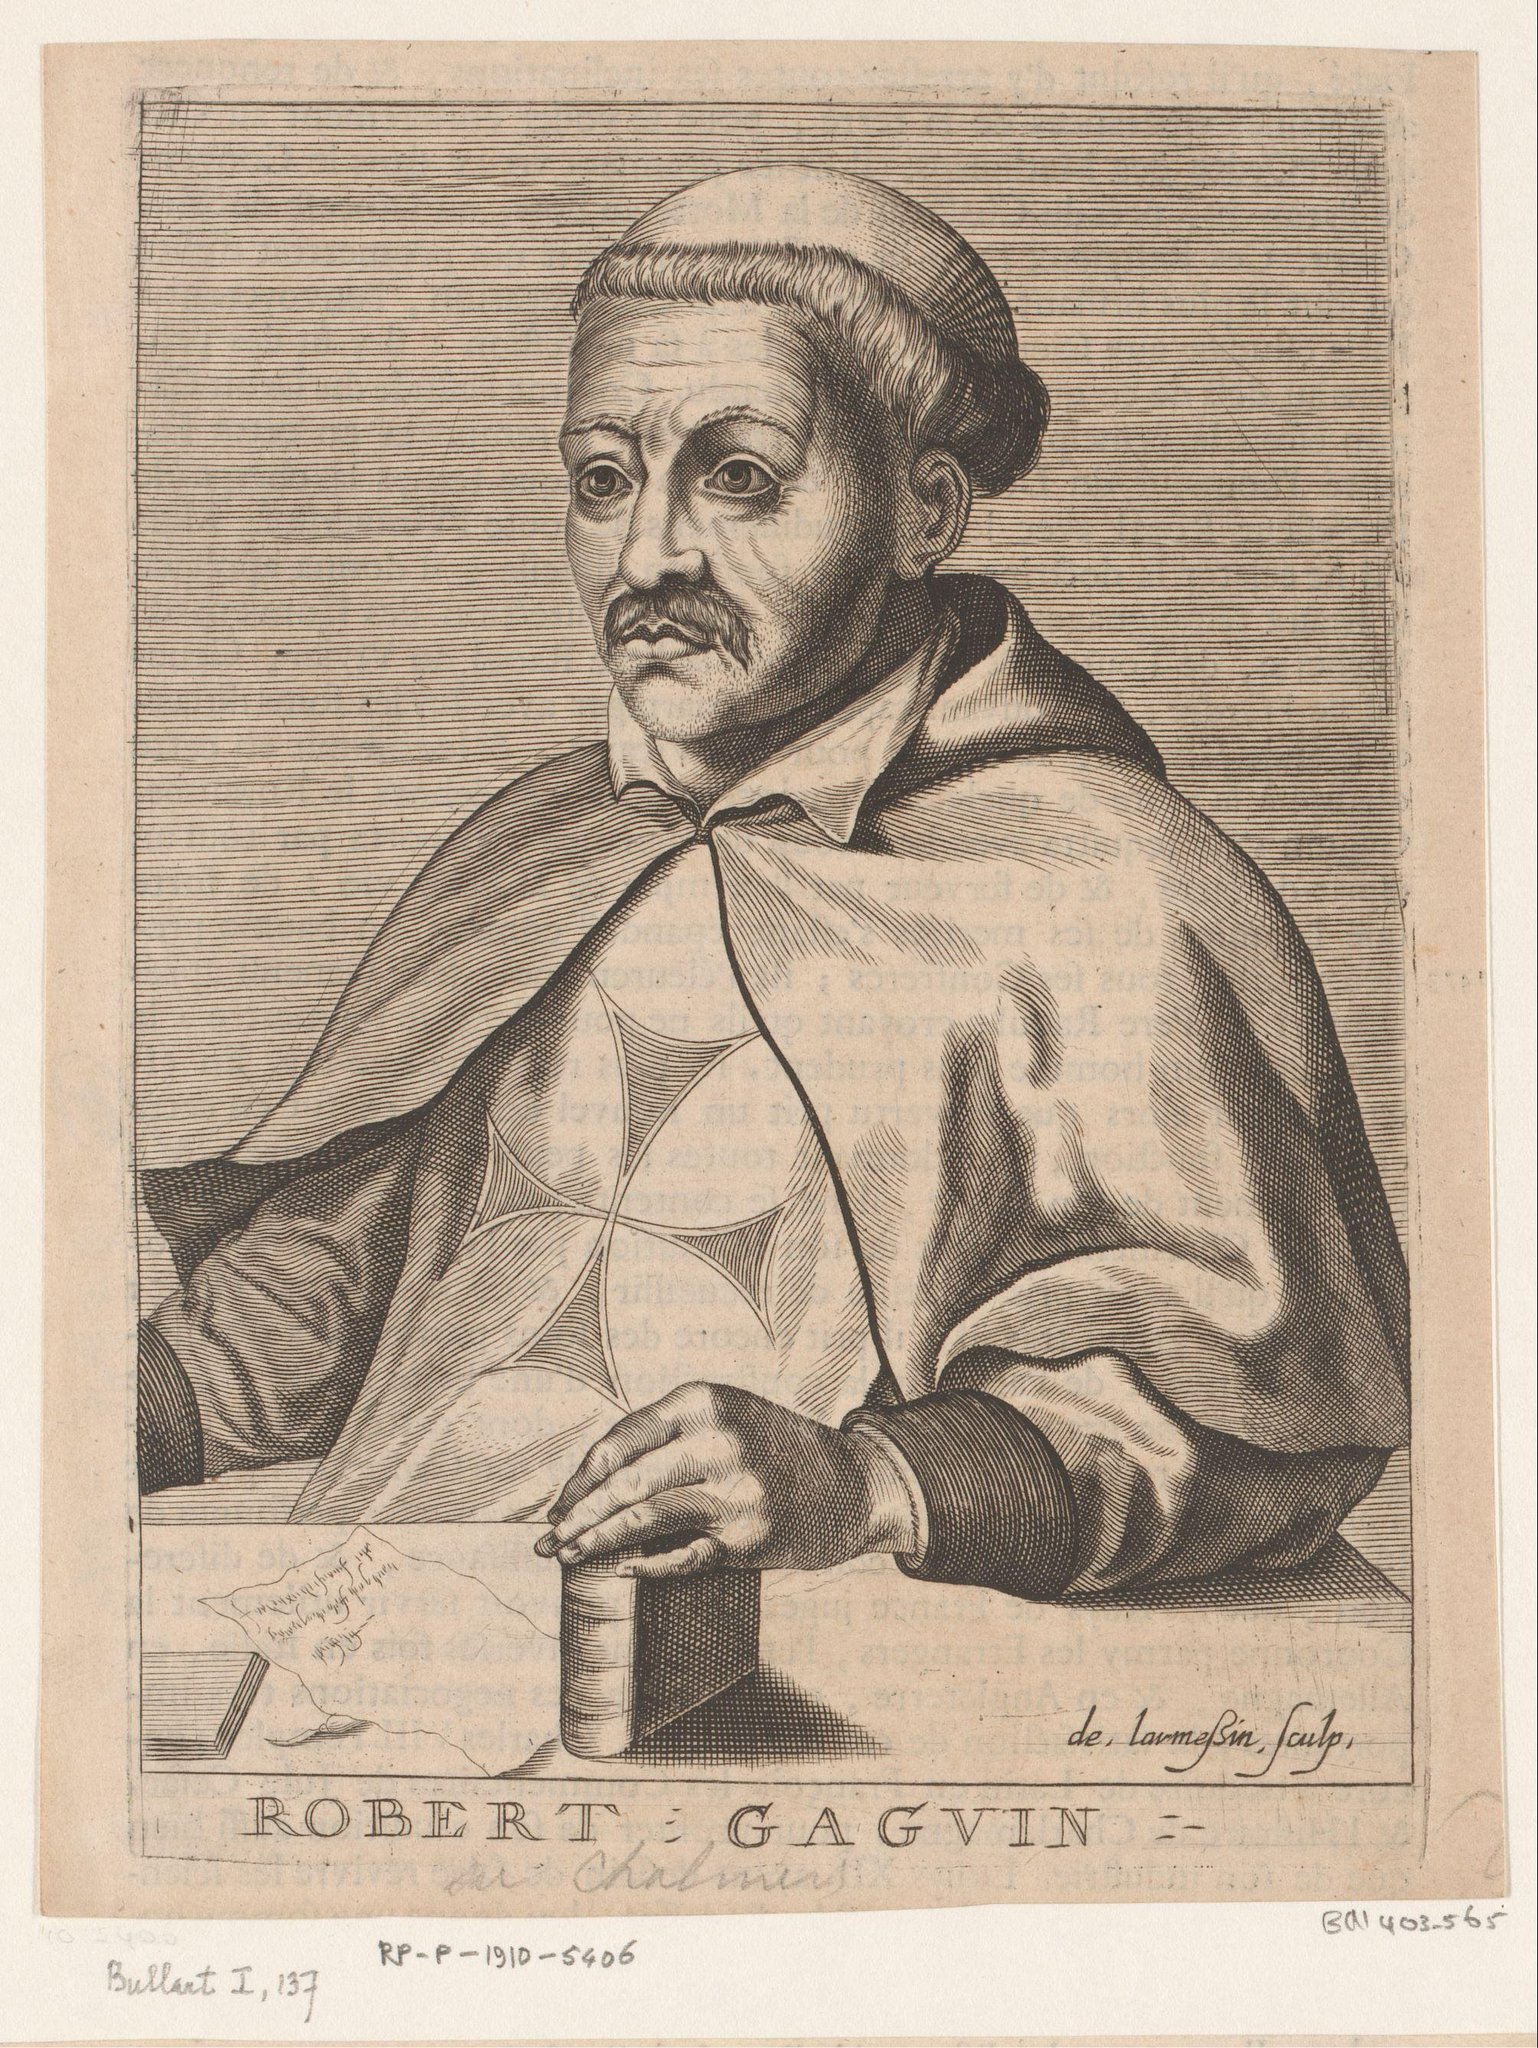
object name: book illustration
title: Portret van Robert Gaguin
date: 1682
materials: paper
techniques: engraving, letterpress printing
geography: brussels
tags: scholar, philosopher, historical persons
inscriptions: collector's mark: Lugt 2228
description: Prent gebruikt voor: Bullart, Isaac. Académie des Sciences et Arts contenant les vies et éloges his. des hommes illustres qui ont excellé en ces professions depuis environ quatre siècles. Brussel: François Foppens, 1682. Het boek werd in 1682 eveneens in Amsterdam uitgegeven door de erfgenamen van Daniel Elzevier. Ieder portret betreft een illustratie bij de biografie van een kunstenaar of geleerde. De meeste portretten werden door Nicolas de Larmessin vervaardigd (162), 93 door De Boulonois en een derde door ongeïdentificeerde prentmakers. Dit betreft een illustratie op p. 137, deel I.